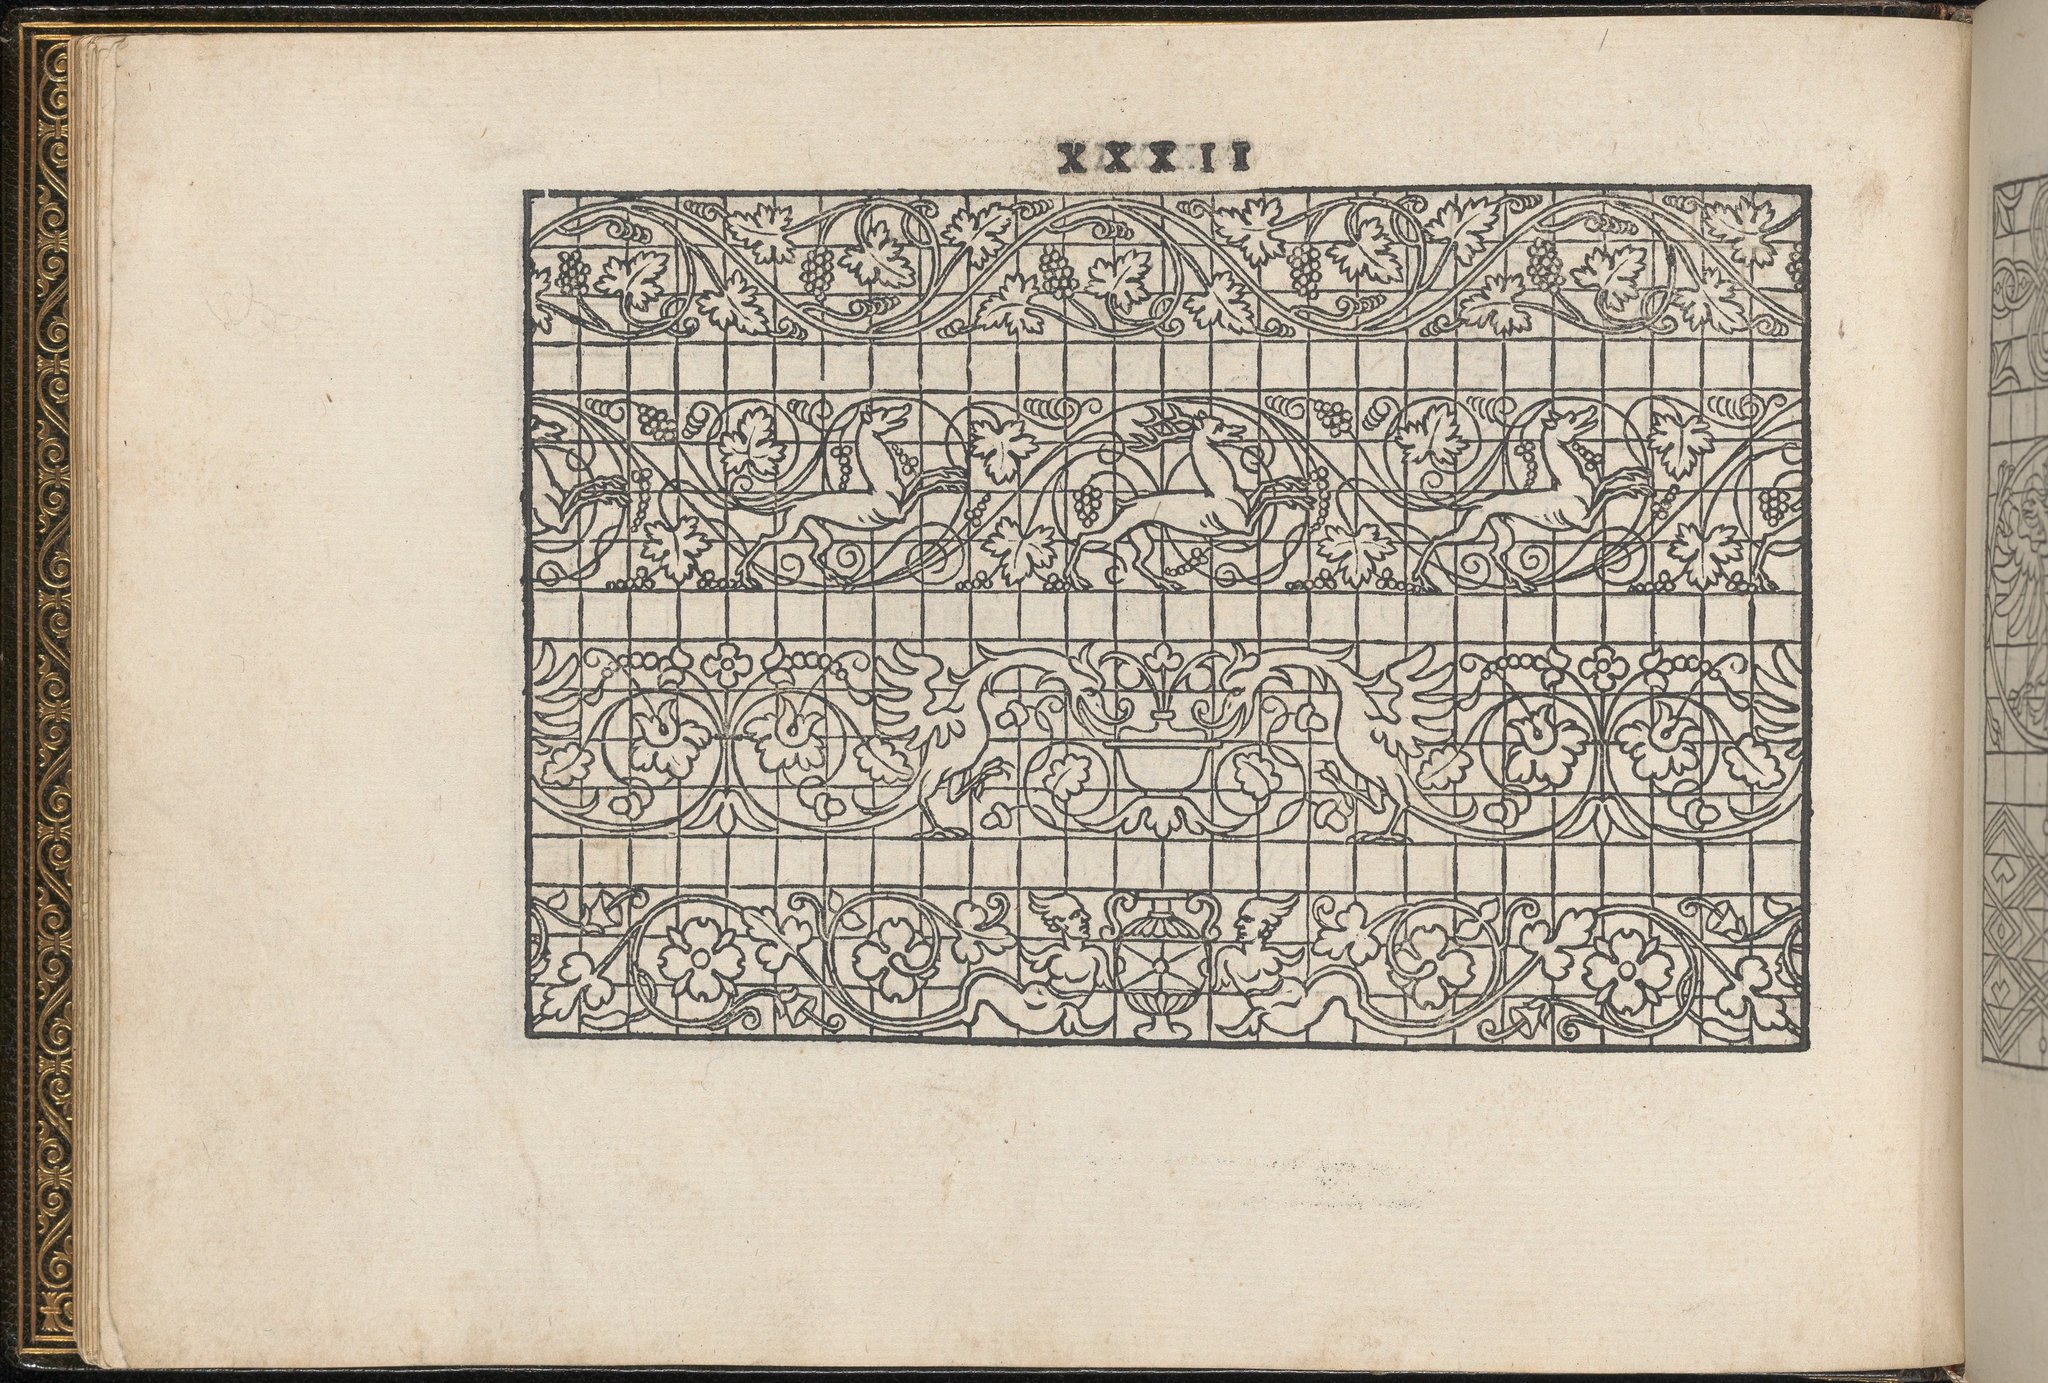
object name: book print ornament architecture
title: La Vera Perfettione del Disegno di varie sorti di recami, page 16 (verso)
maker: giovanni ostaus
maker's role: publisher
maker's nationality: italian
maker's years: 1507-1607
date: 1567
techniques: woodcut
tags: grapes,dragons,flowers,vines